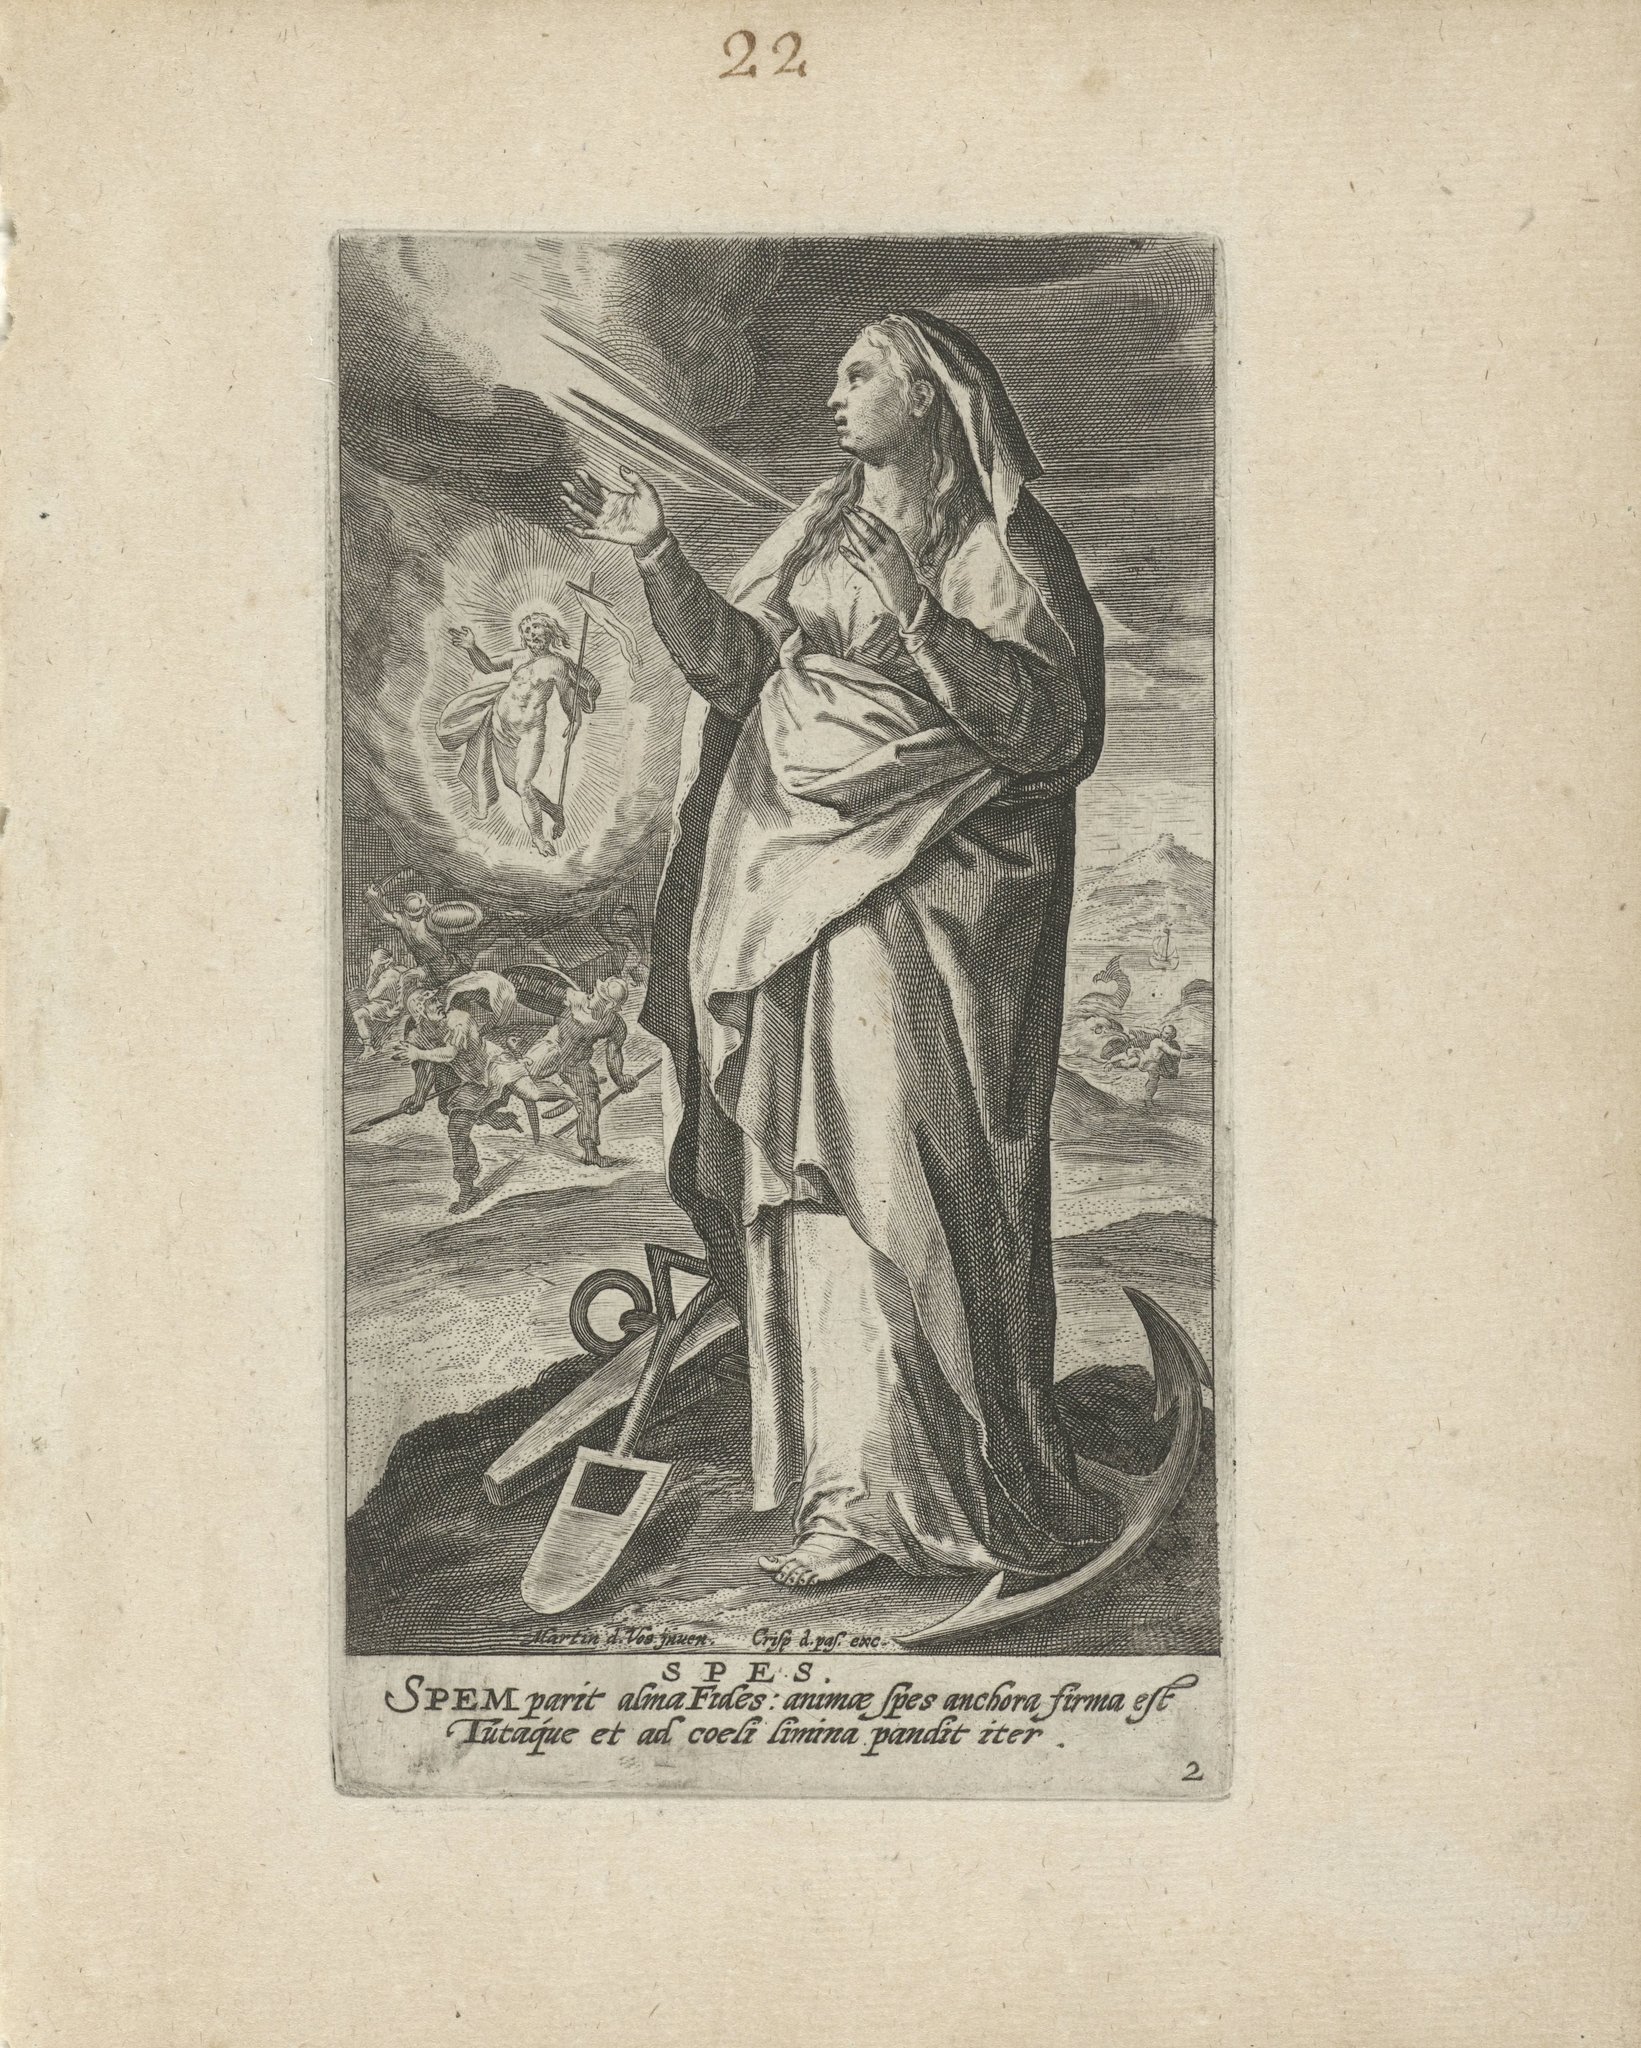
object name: print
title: De zeven deugden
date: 1580-1588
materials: paper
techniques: engraving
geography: antwerp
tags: hope, 'spes'; 'speranza divina e certa' (ripa) ~ one of the three theological virtues, christ, usually holding a banner, arises from the grave; often combined with sleeping and/or frightened soldiers, after a three-day sojourn in the belly of the monster jonah is cast on dry land; jonah may be shown nude and bald-headed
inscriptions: number: ‘22’, collector's mark: Lugt 2760, collector's mark: Lugt 2228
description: Landschap met de vrouwelijke personificatie van Hoop (Spes), een van de drie theologische deugden, die naar de hemel opkijkt. Aan haar voeten een anker en een spade. Rechts op de achtergrond de verrijzenis van Christus. Links op de achtergrond wordt Jona door de vis uitgespuwd. In de marge een tweeregelig onderschrift in het Latijn. Tweede prent uit een serie met de deugden.